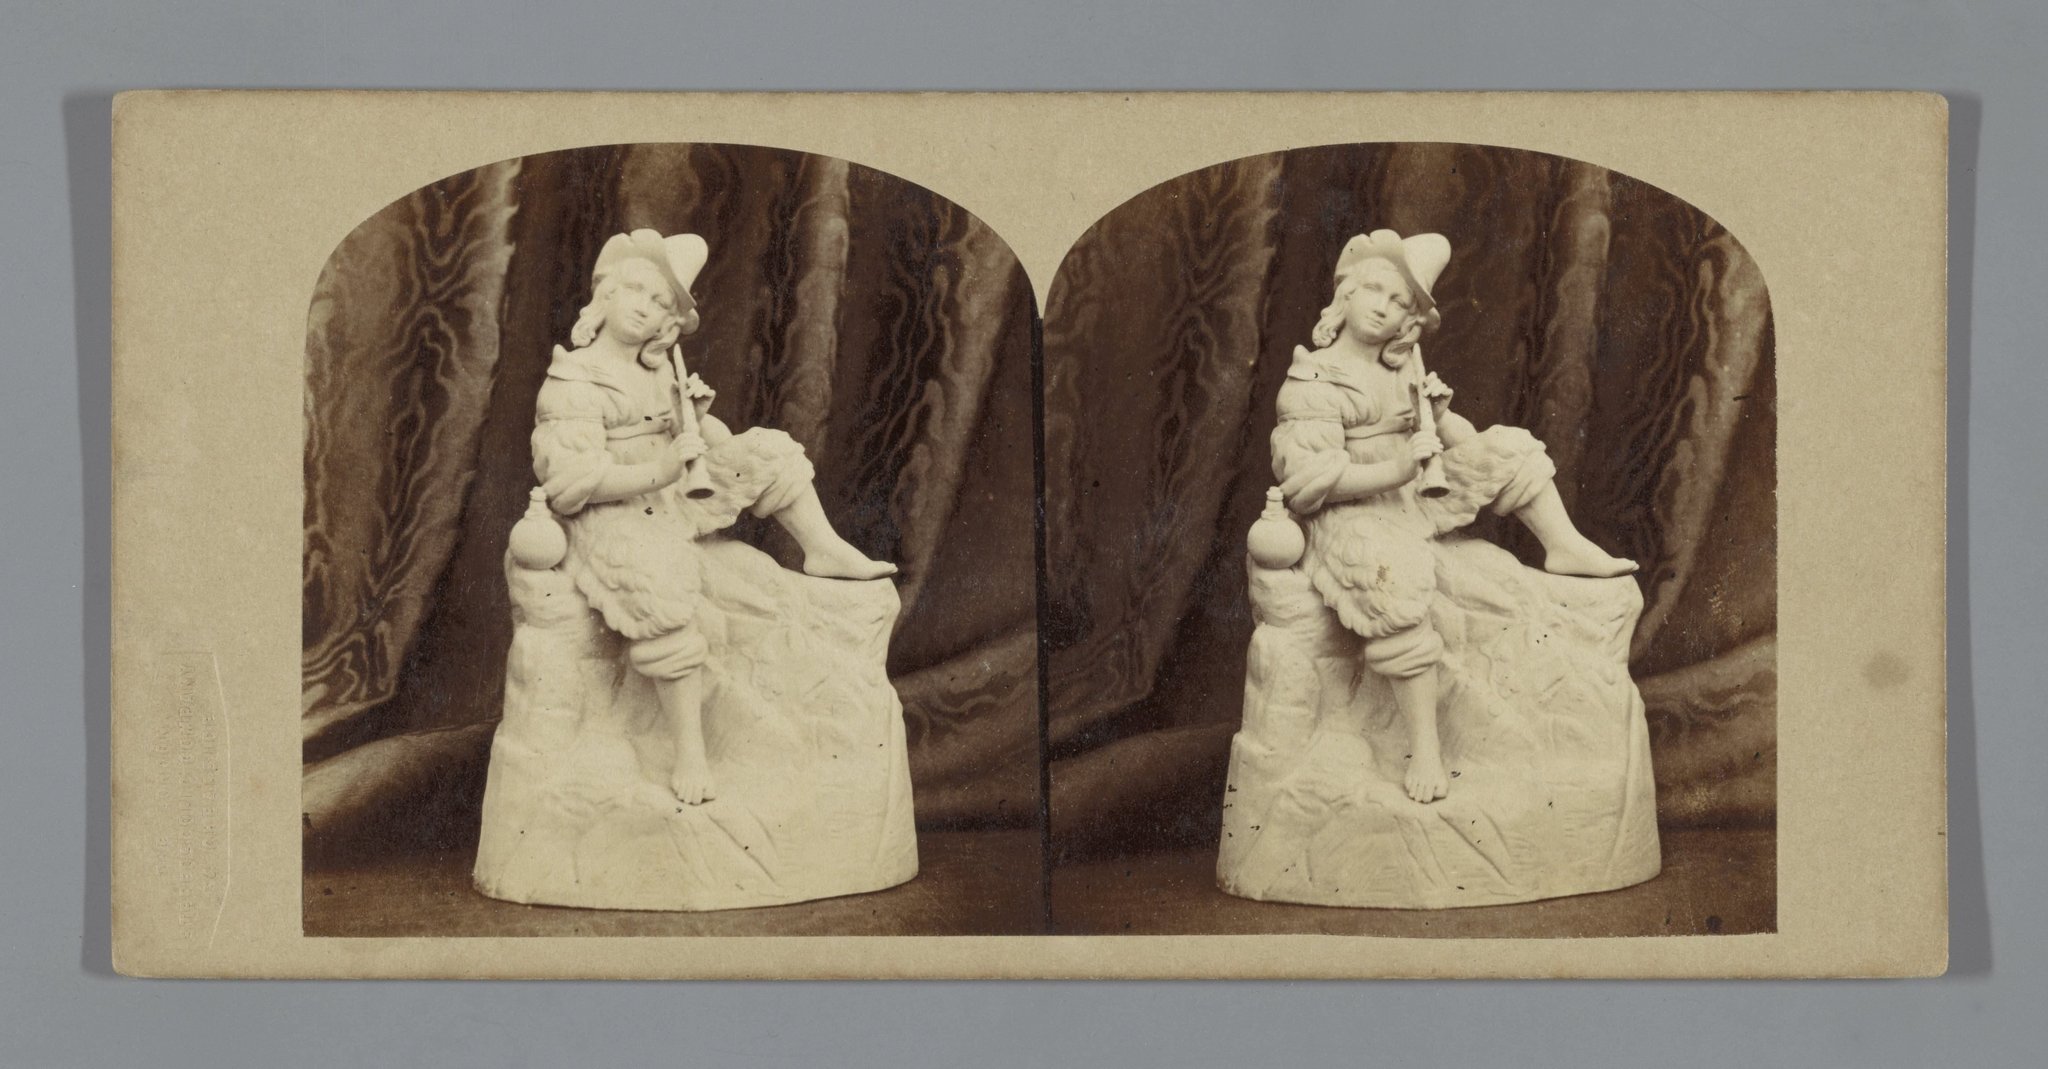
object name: stereograph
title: The Mountain Minstrel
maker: Anonymous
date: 1855-1880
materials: cardboard, photographic support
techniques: albumen print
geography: london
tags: musician, sculpture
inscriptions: number: ‘12’